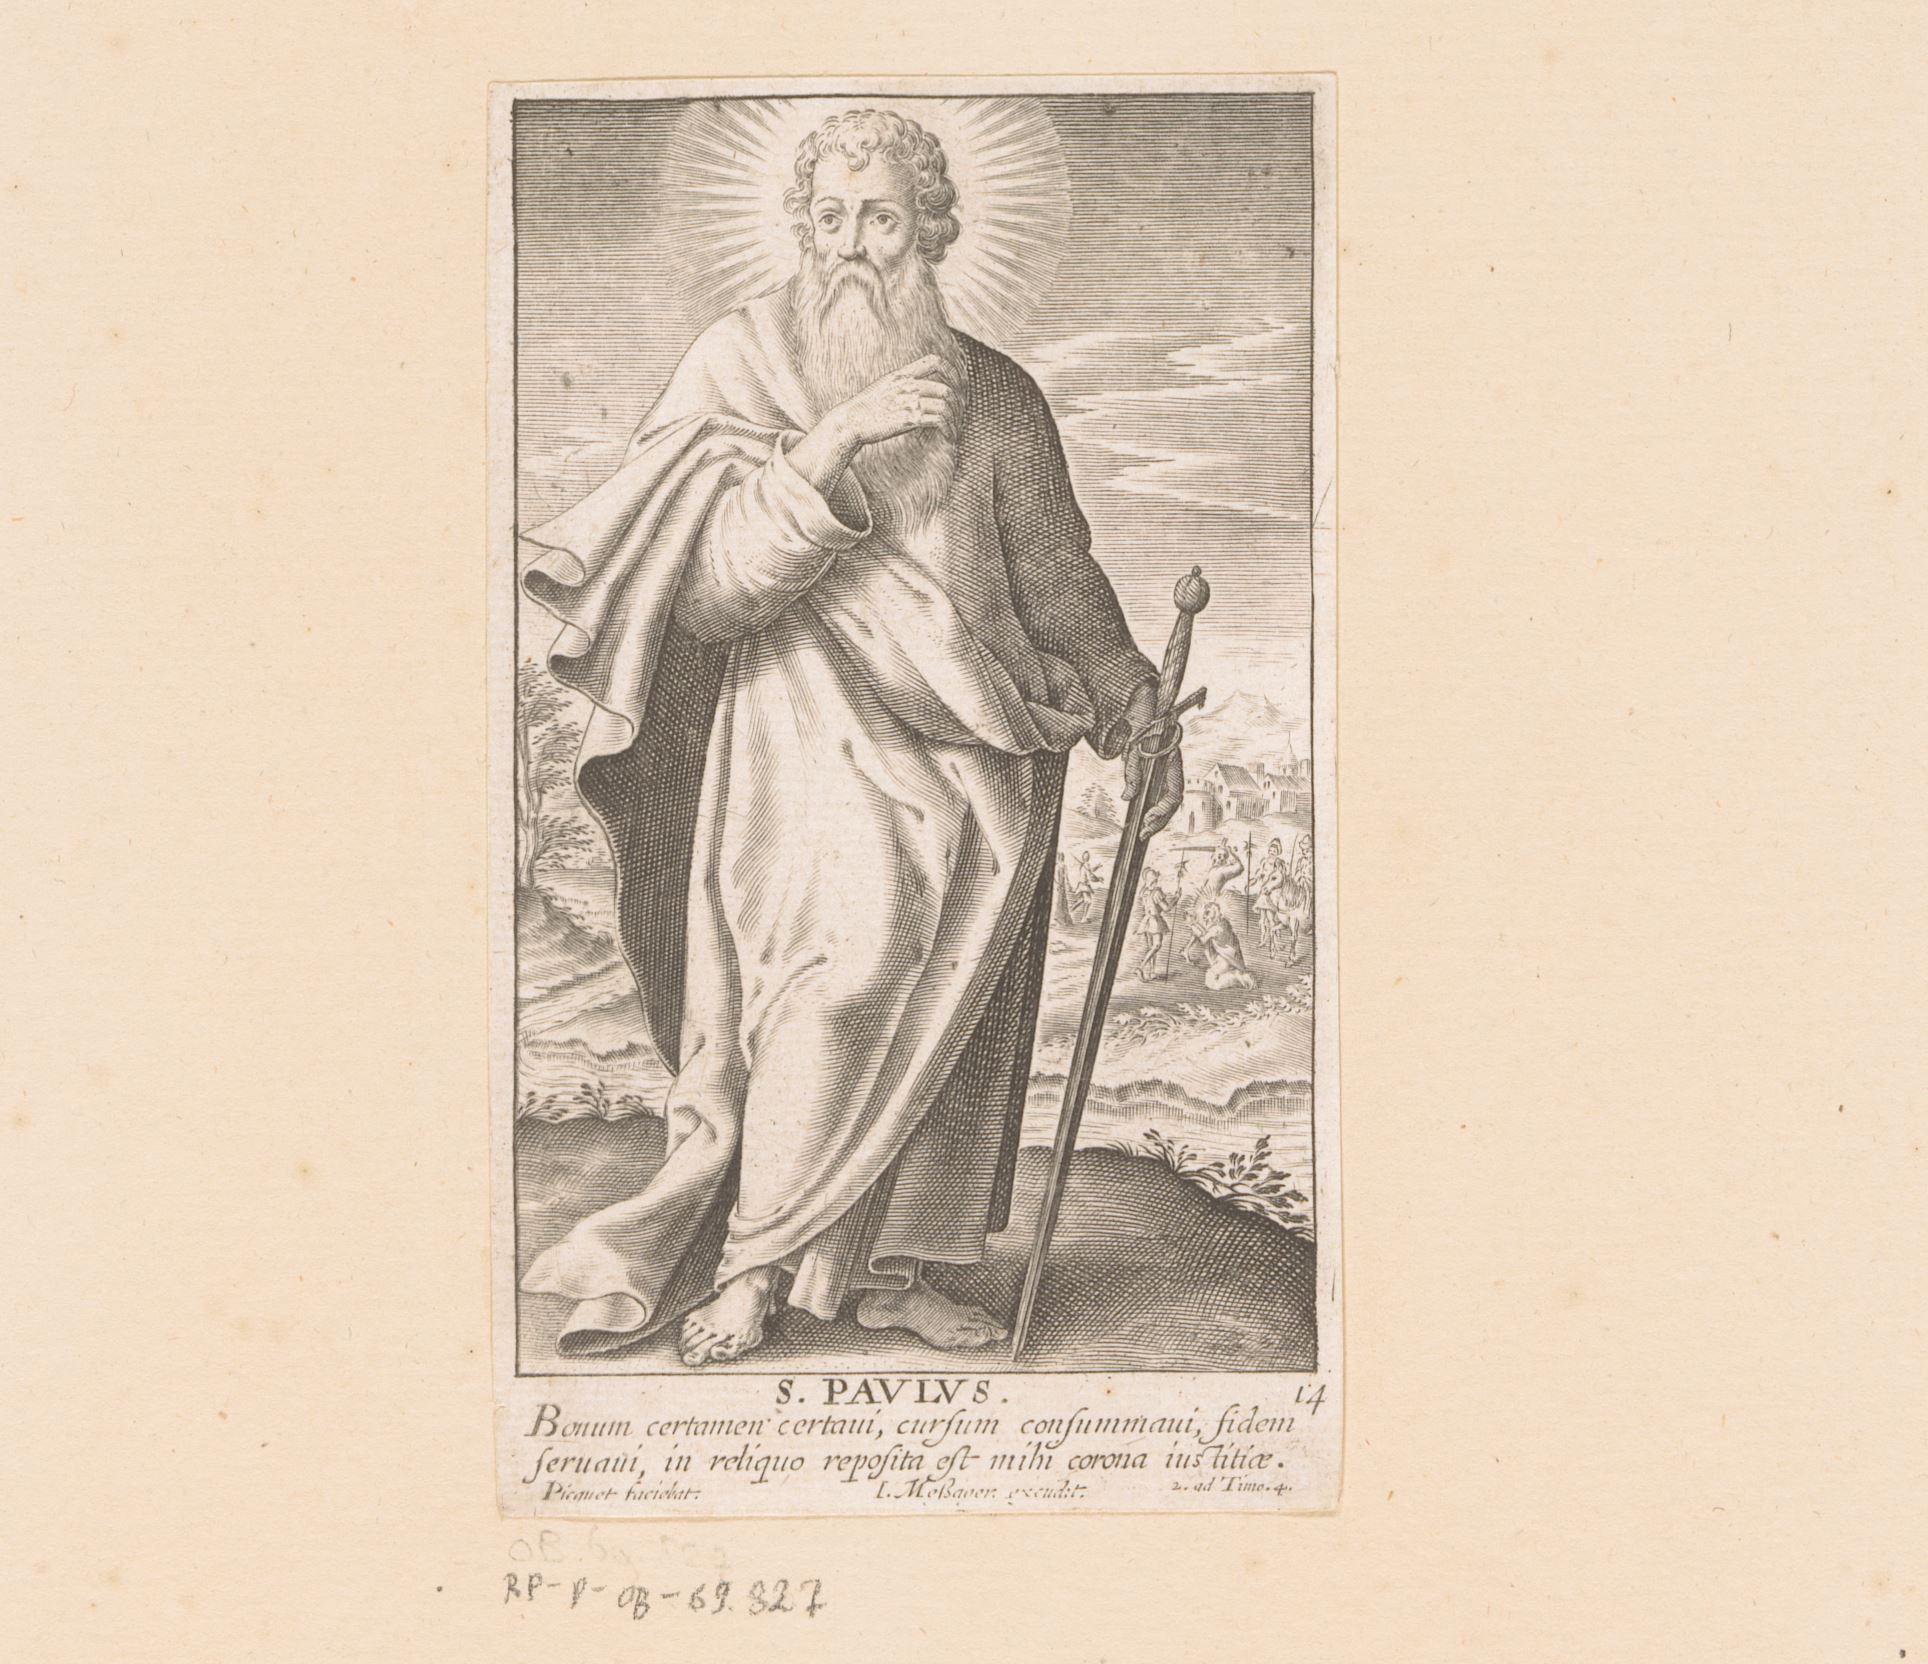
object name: print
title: Staande heiligen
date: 1608-1649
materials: paper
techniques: engraving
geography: france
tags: the apostle paul of tarsus; possible attributes: book, scroll, sword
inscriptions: collector's mark: Lugt 240